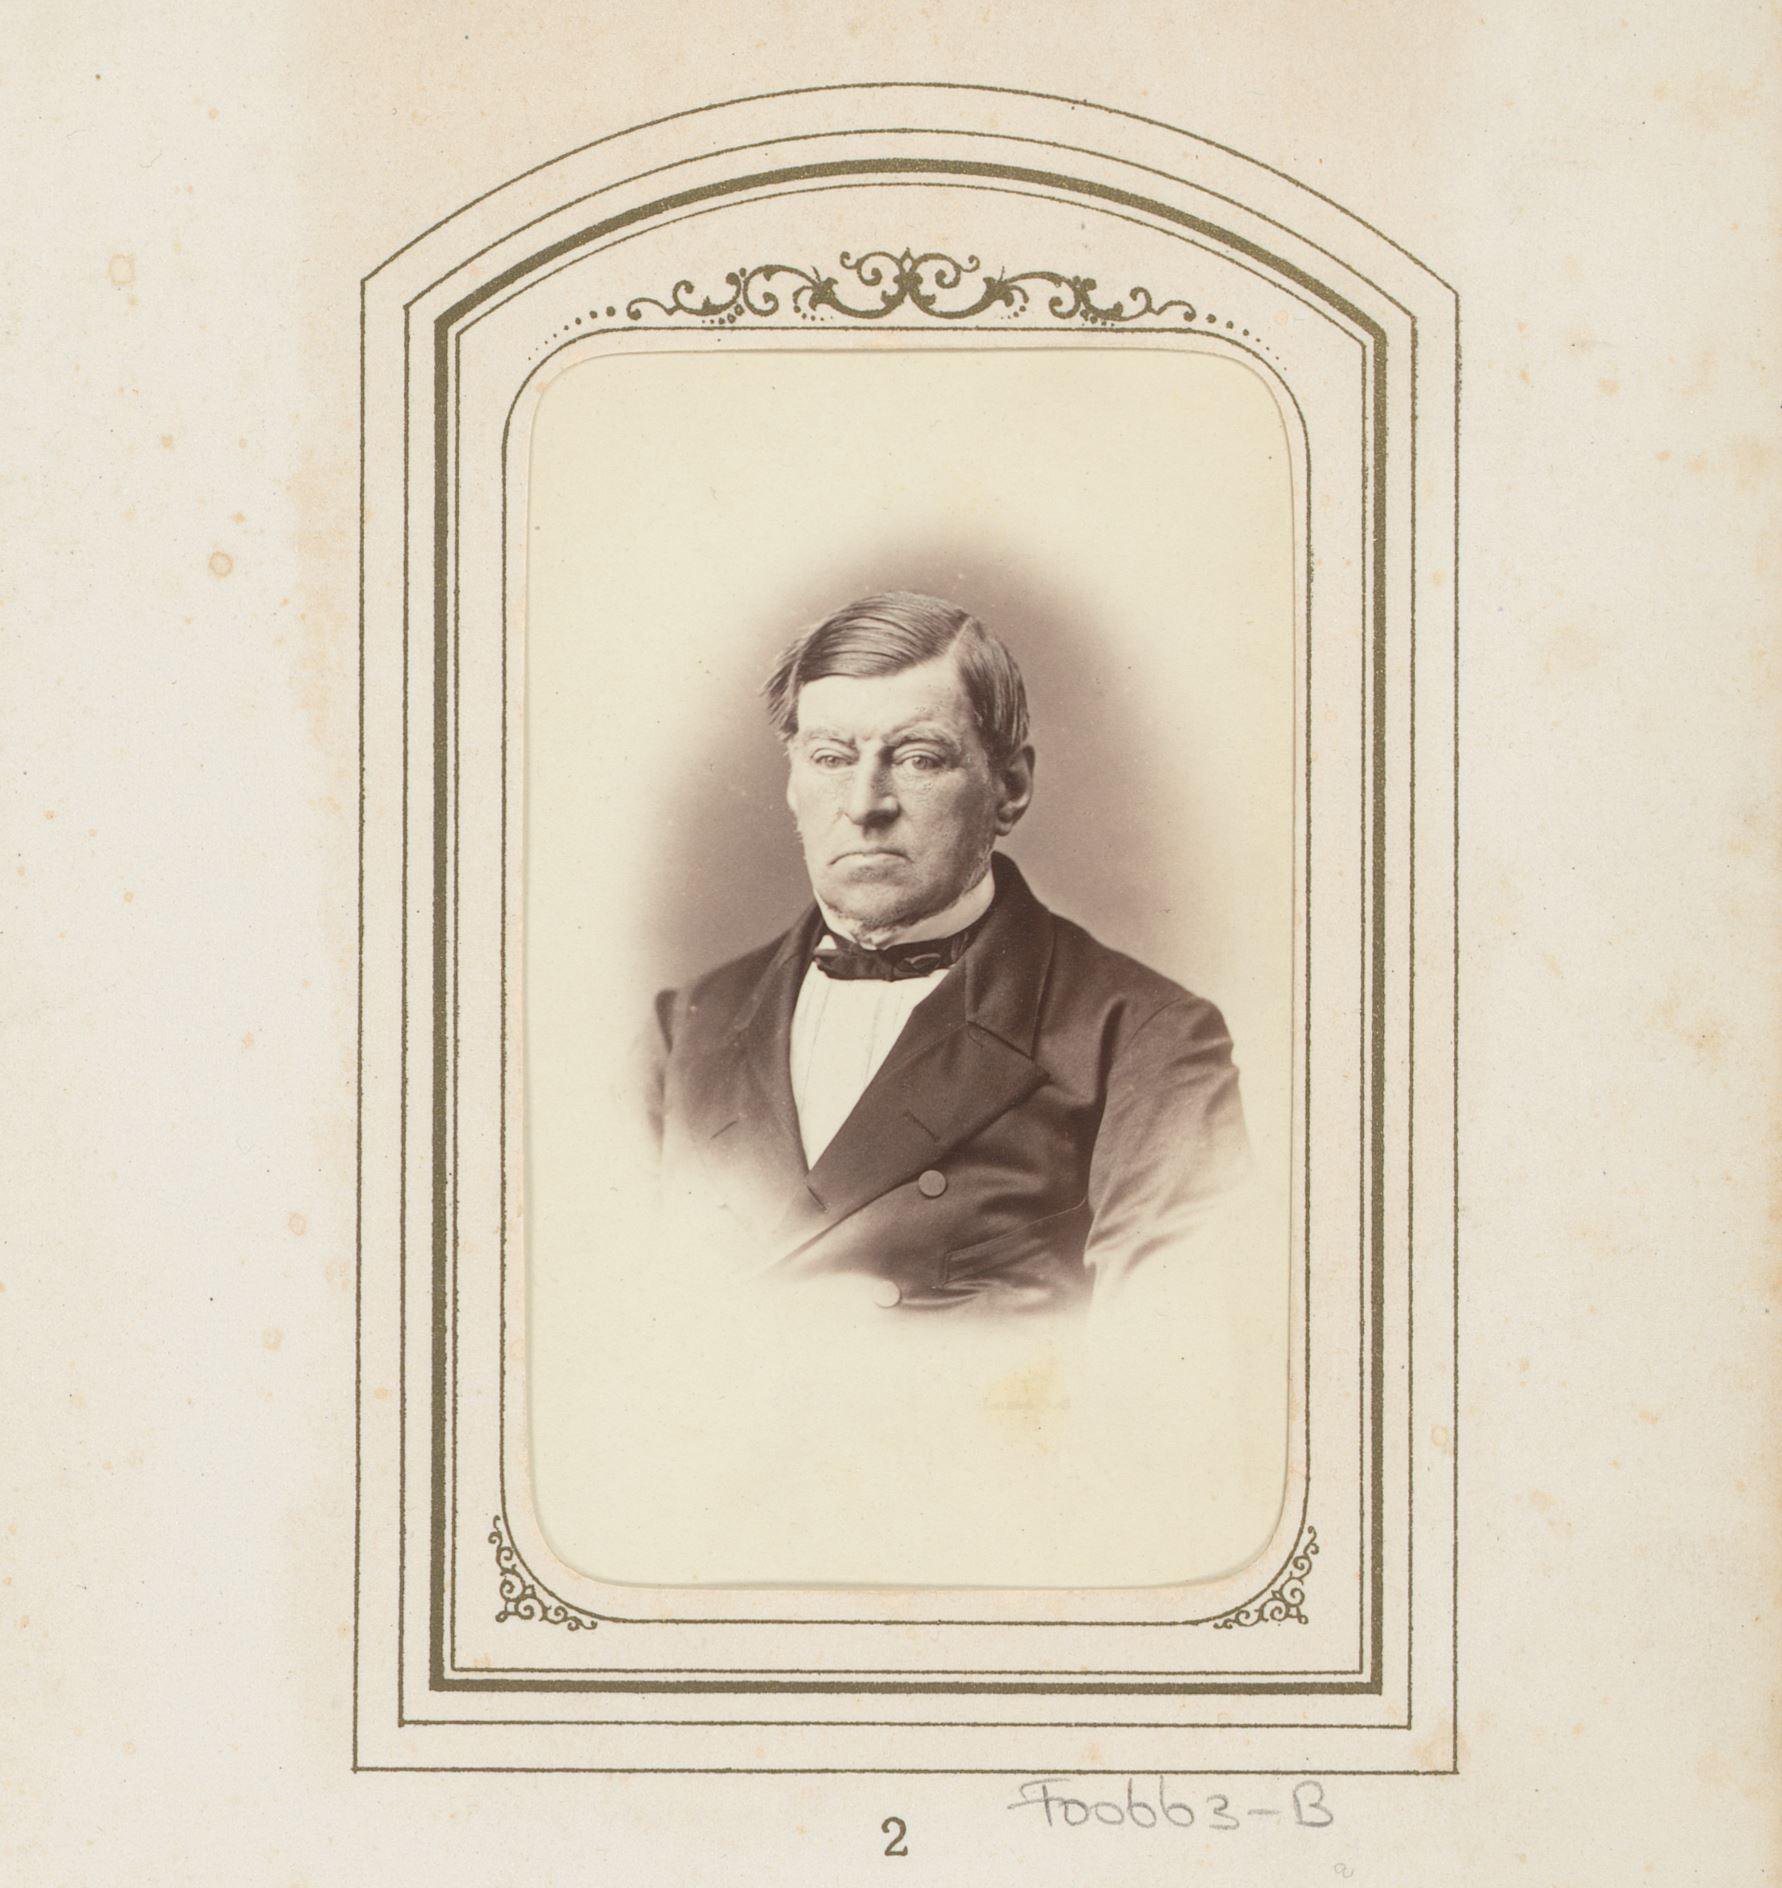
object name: album leaf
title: Portret van een man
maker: eduard fuchs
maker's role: painter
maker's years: 1832-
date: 1859-1870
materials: cardboard, photographic support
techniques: albumen print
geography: leeuwarden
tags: historical persons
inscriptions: number: ‘2’, inscription: ‘Photographie/ E. Fuchs/ Leeuwarden (...)’